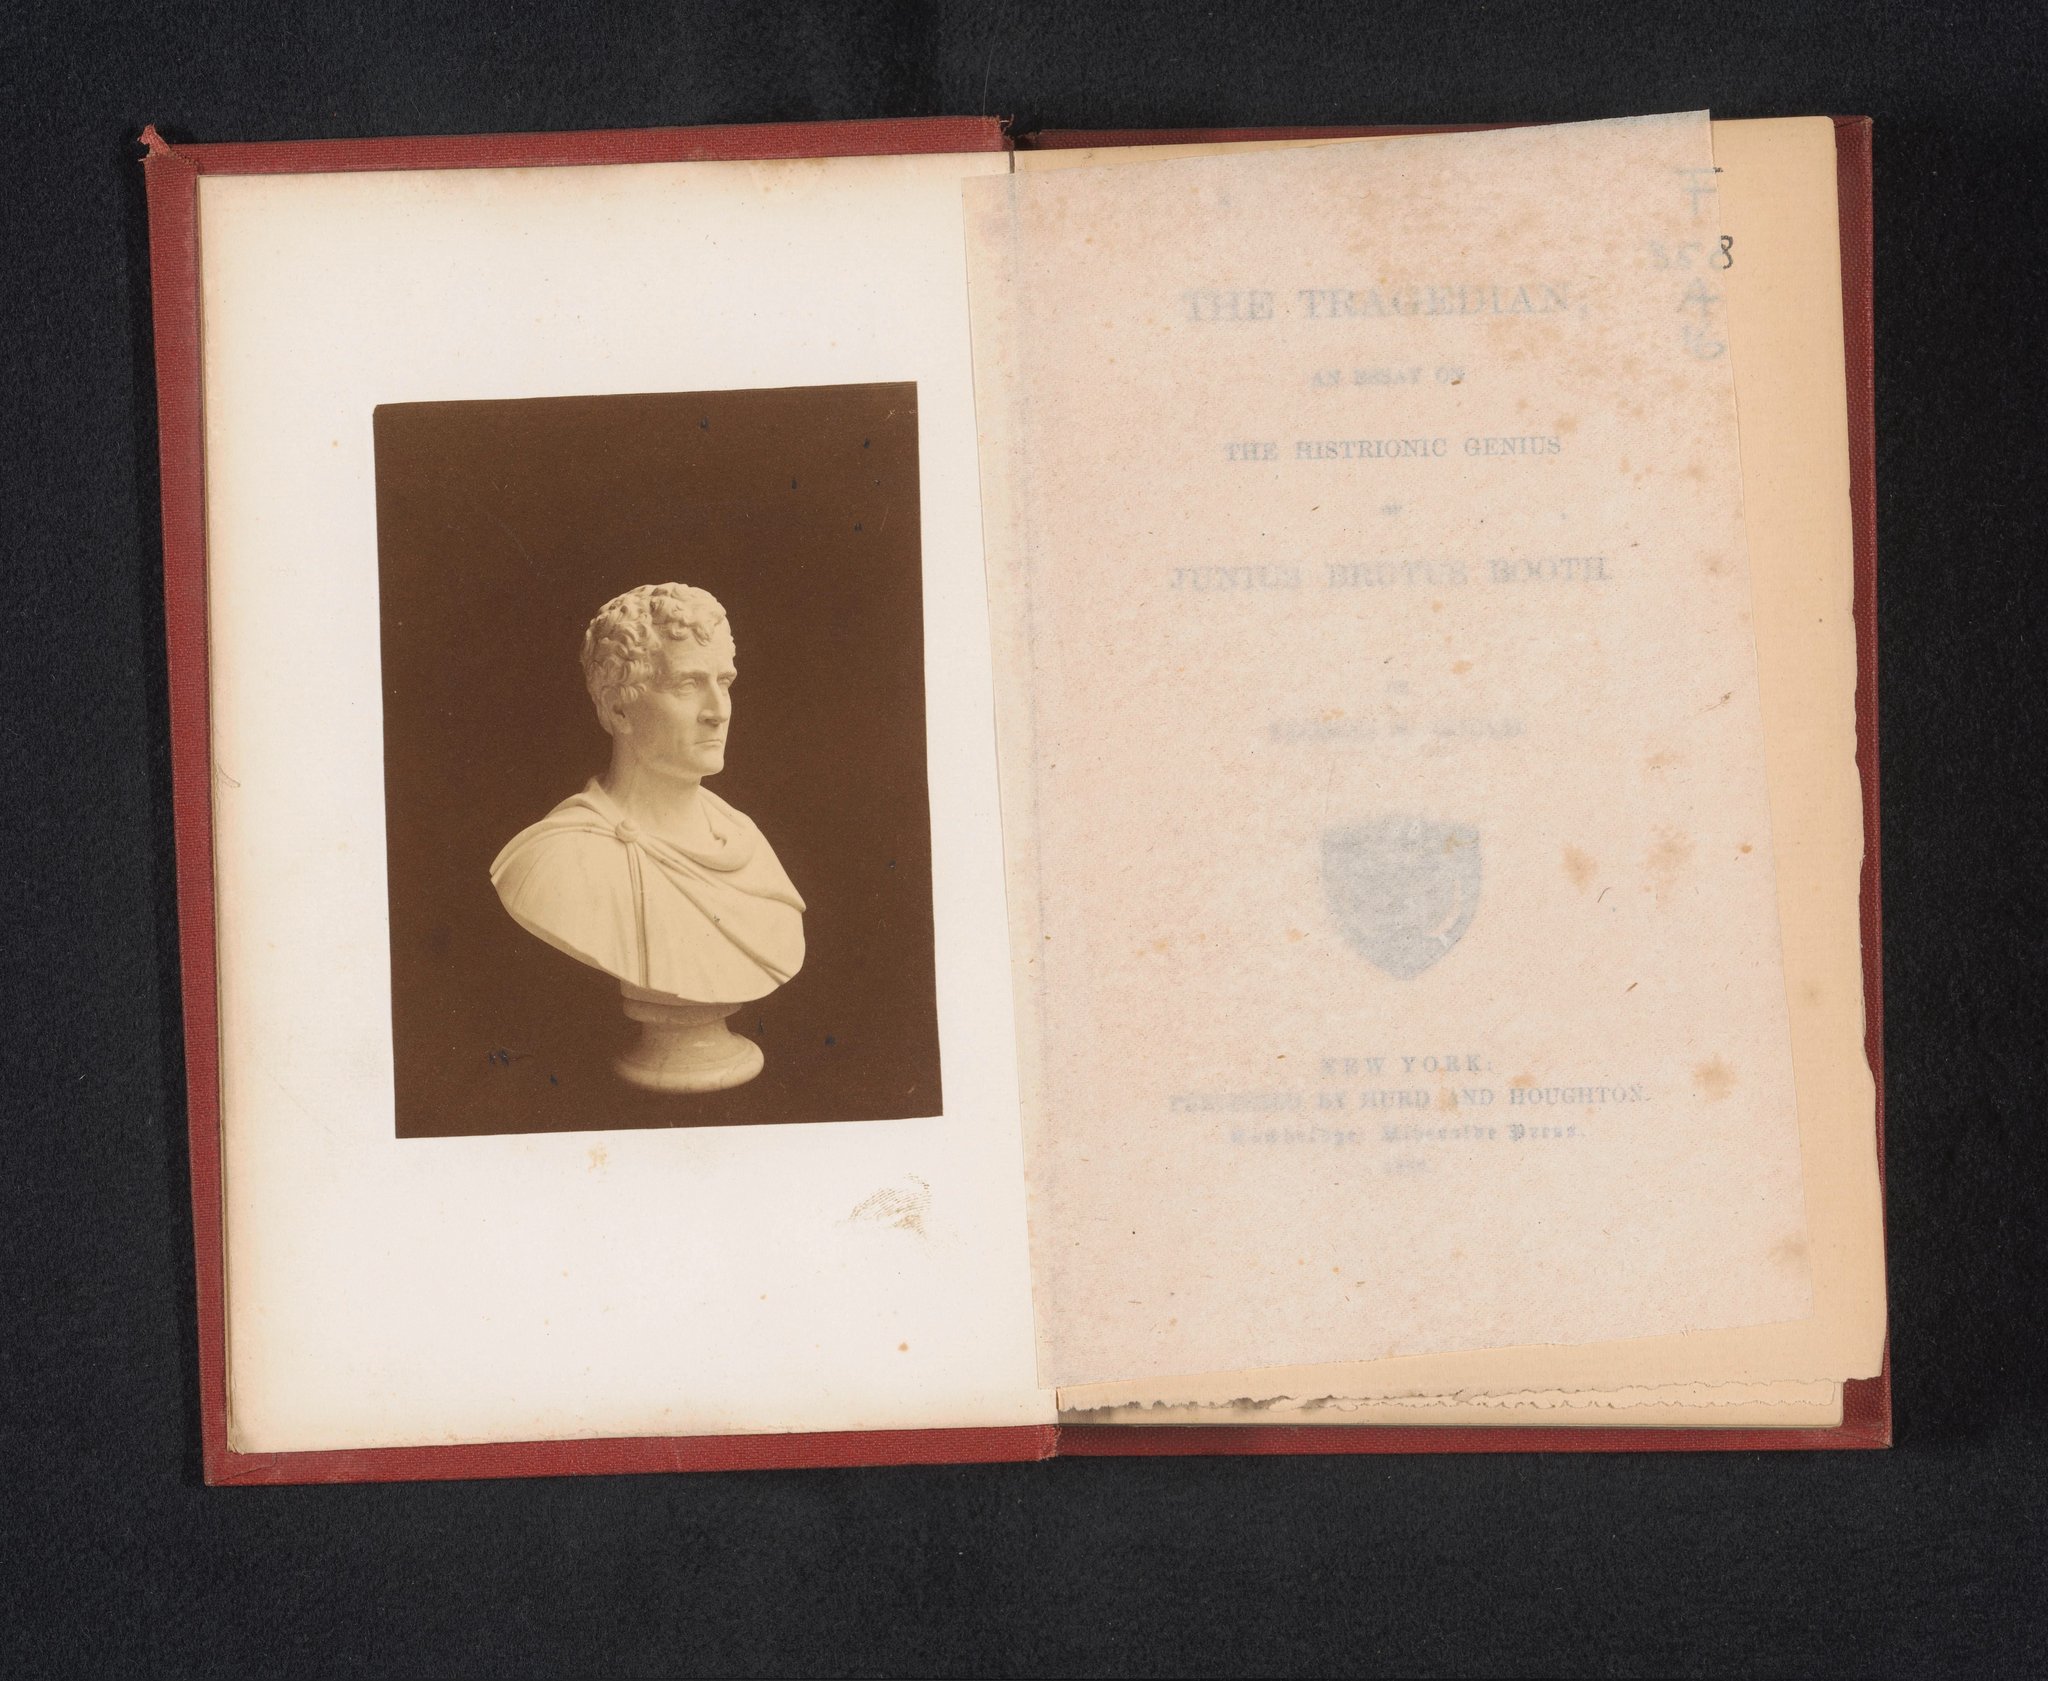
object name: photograph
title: Buste van Junius Brutus Booth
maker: h.g. smith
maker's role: fotograaf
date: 1863-1868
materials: photographic support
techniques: albumen print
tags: historical persons